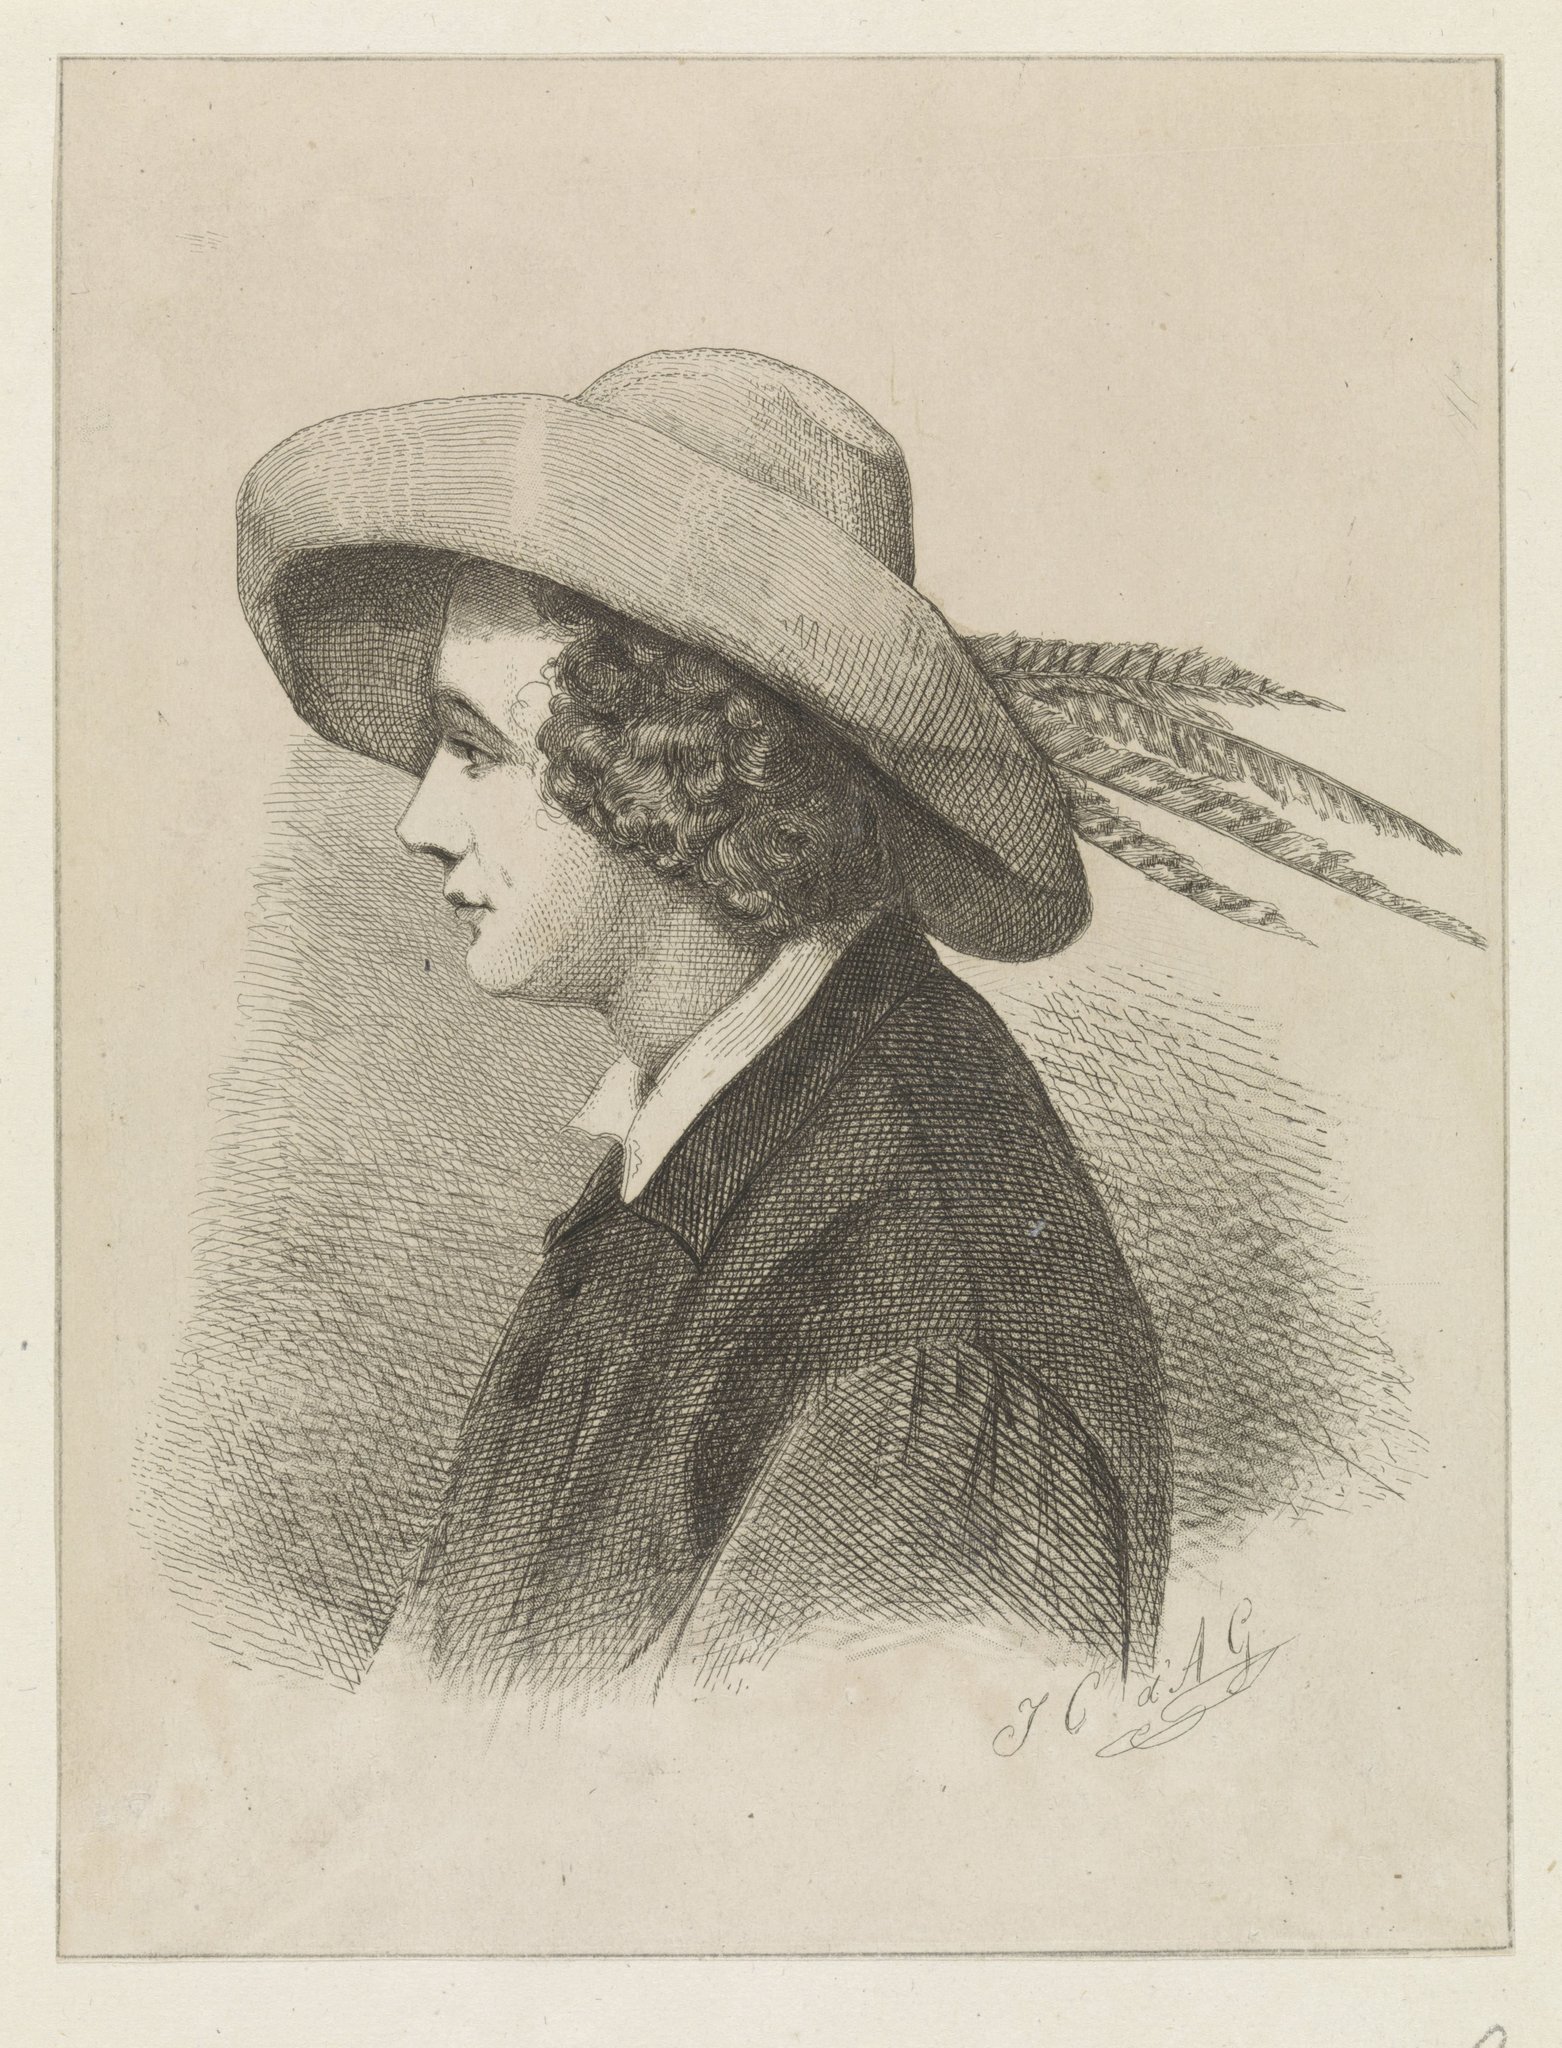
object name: print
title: Portret van Martinus Antonius Kuytenbrouwer in profiel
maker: johannes christiaan d arnaud gerkens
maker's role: draughtsman, print maker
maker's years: 1823-1892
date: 1833-1890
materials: paper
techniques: etching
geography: the hague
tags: paris, painter, draughtsman, martinus antonius kuytenbrouwer jr.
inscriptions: collector's mark: Lugt 2228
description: Portret van Martinus Antonius Kuytenbrouwer, een schilder aan het hof van Napoleon III. Buste in profiel naar links. Kuytenbrouwer draagt een hoed met veren.